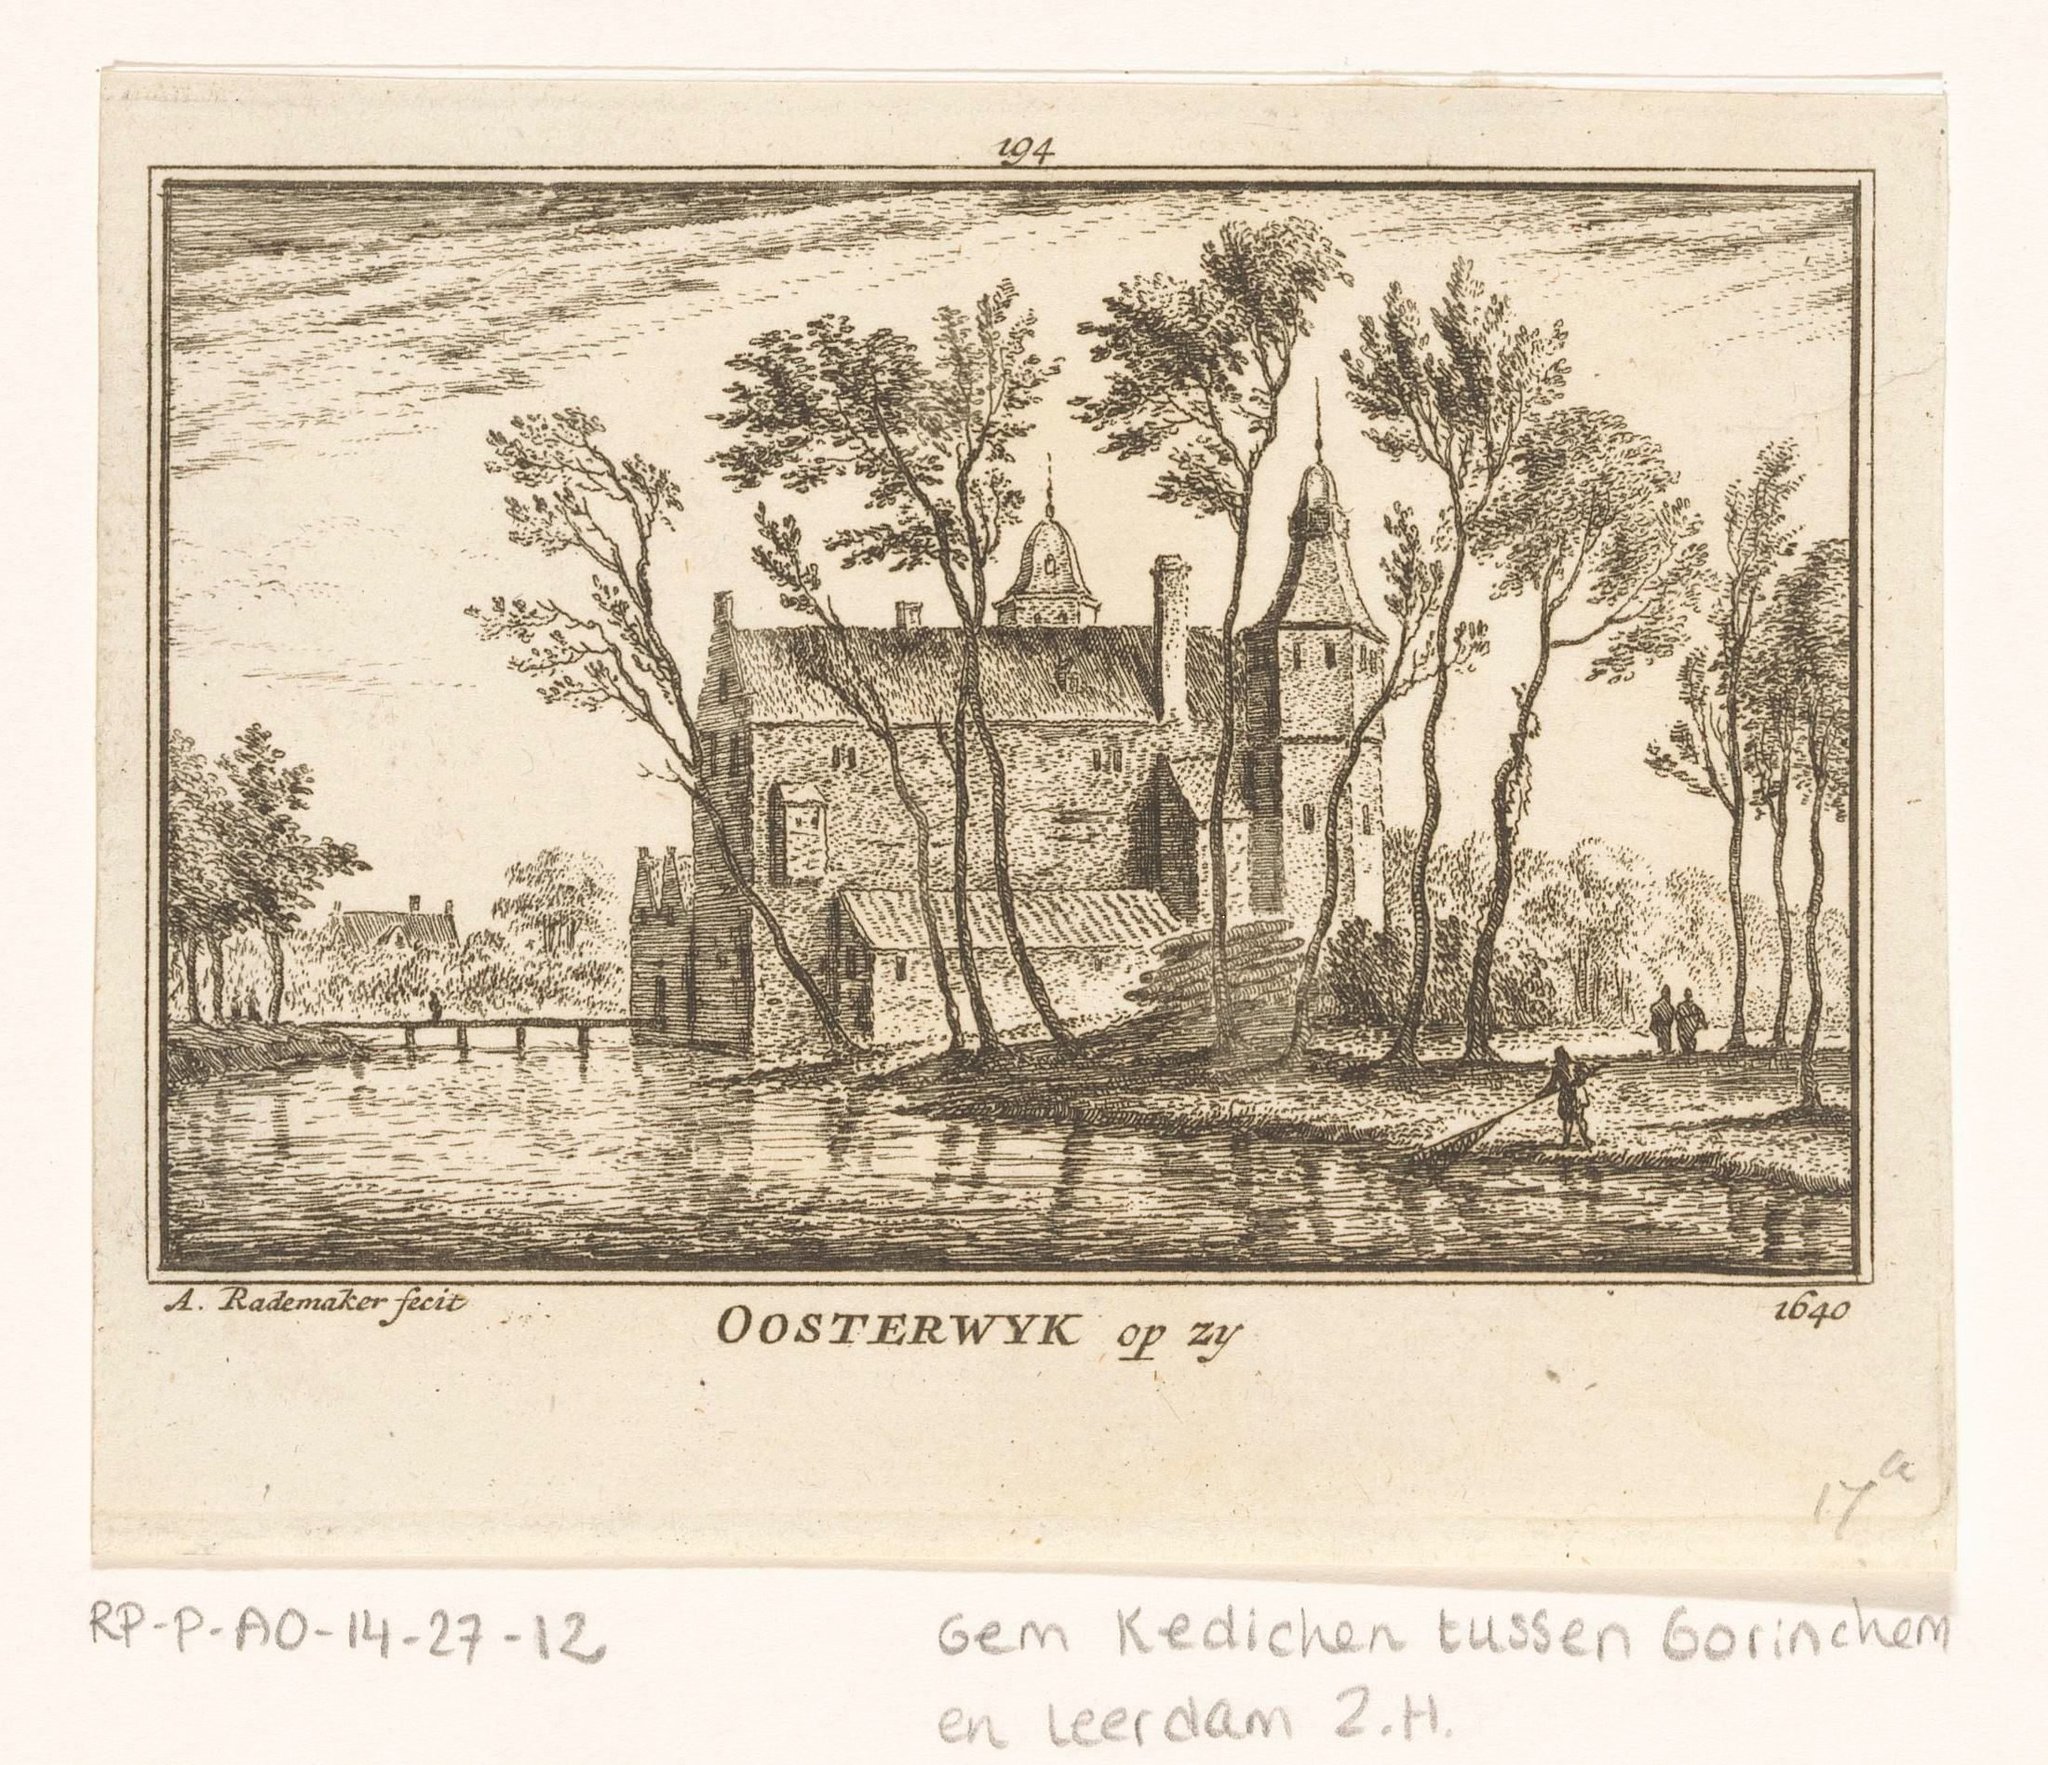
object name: book illustration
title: Gezicht op Huis Oosterwijk, 1640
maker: abraham rademaker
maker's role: draughtsman, print maker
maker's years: 1676-1735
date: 1725-1803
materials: paper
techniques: engraving, etching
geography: amsterdam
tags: castle, fisherman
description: Prent ook gebruikt in: Rademaker, Abraham. Kabinet van Nederlandsche outheden en gezichten: vervat in 300 konstplaaten (…). 2 delen. Amsterdam: Willem Barents, 1725, dl. 2, ill. 194. Na 1725 is deze prent nog in verschillende heruitgaven verschenen, uitgegeven in 1727-1733, 1770-1771 en 1792-1803. Uit welke uitgave het huidige exemplaar precies komt is niet na te gaan.